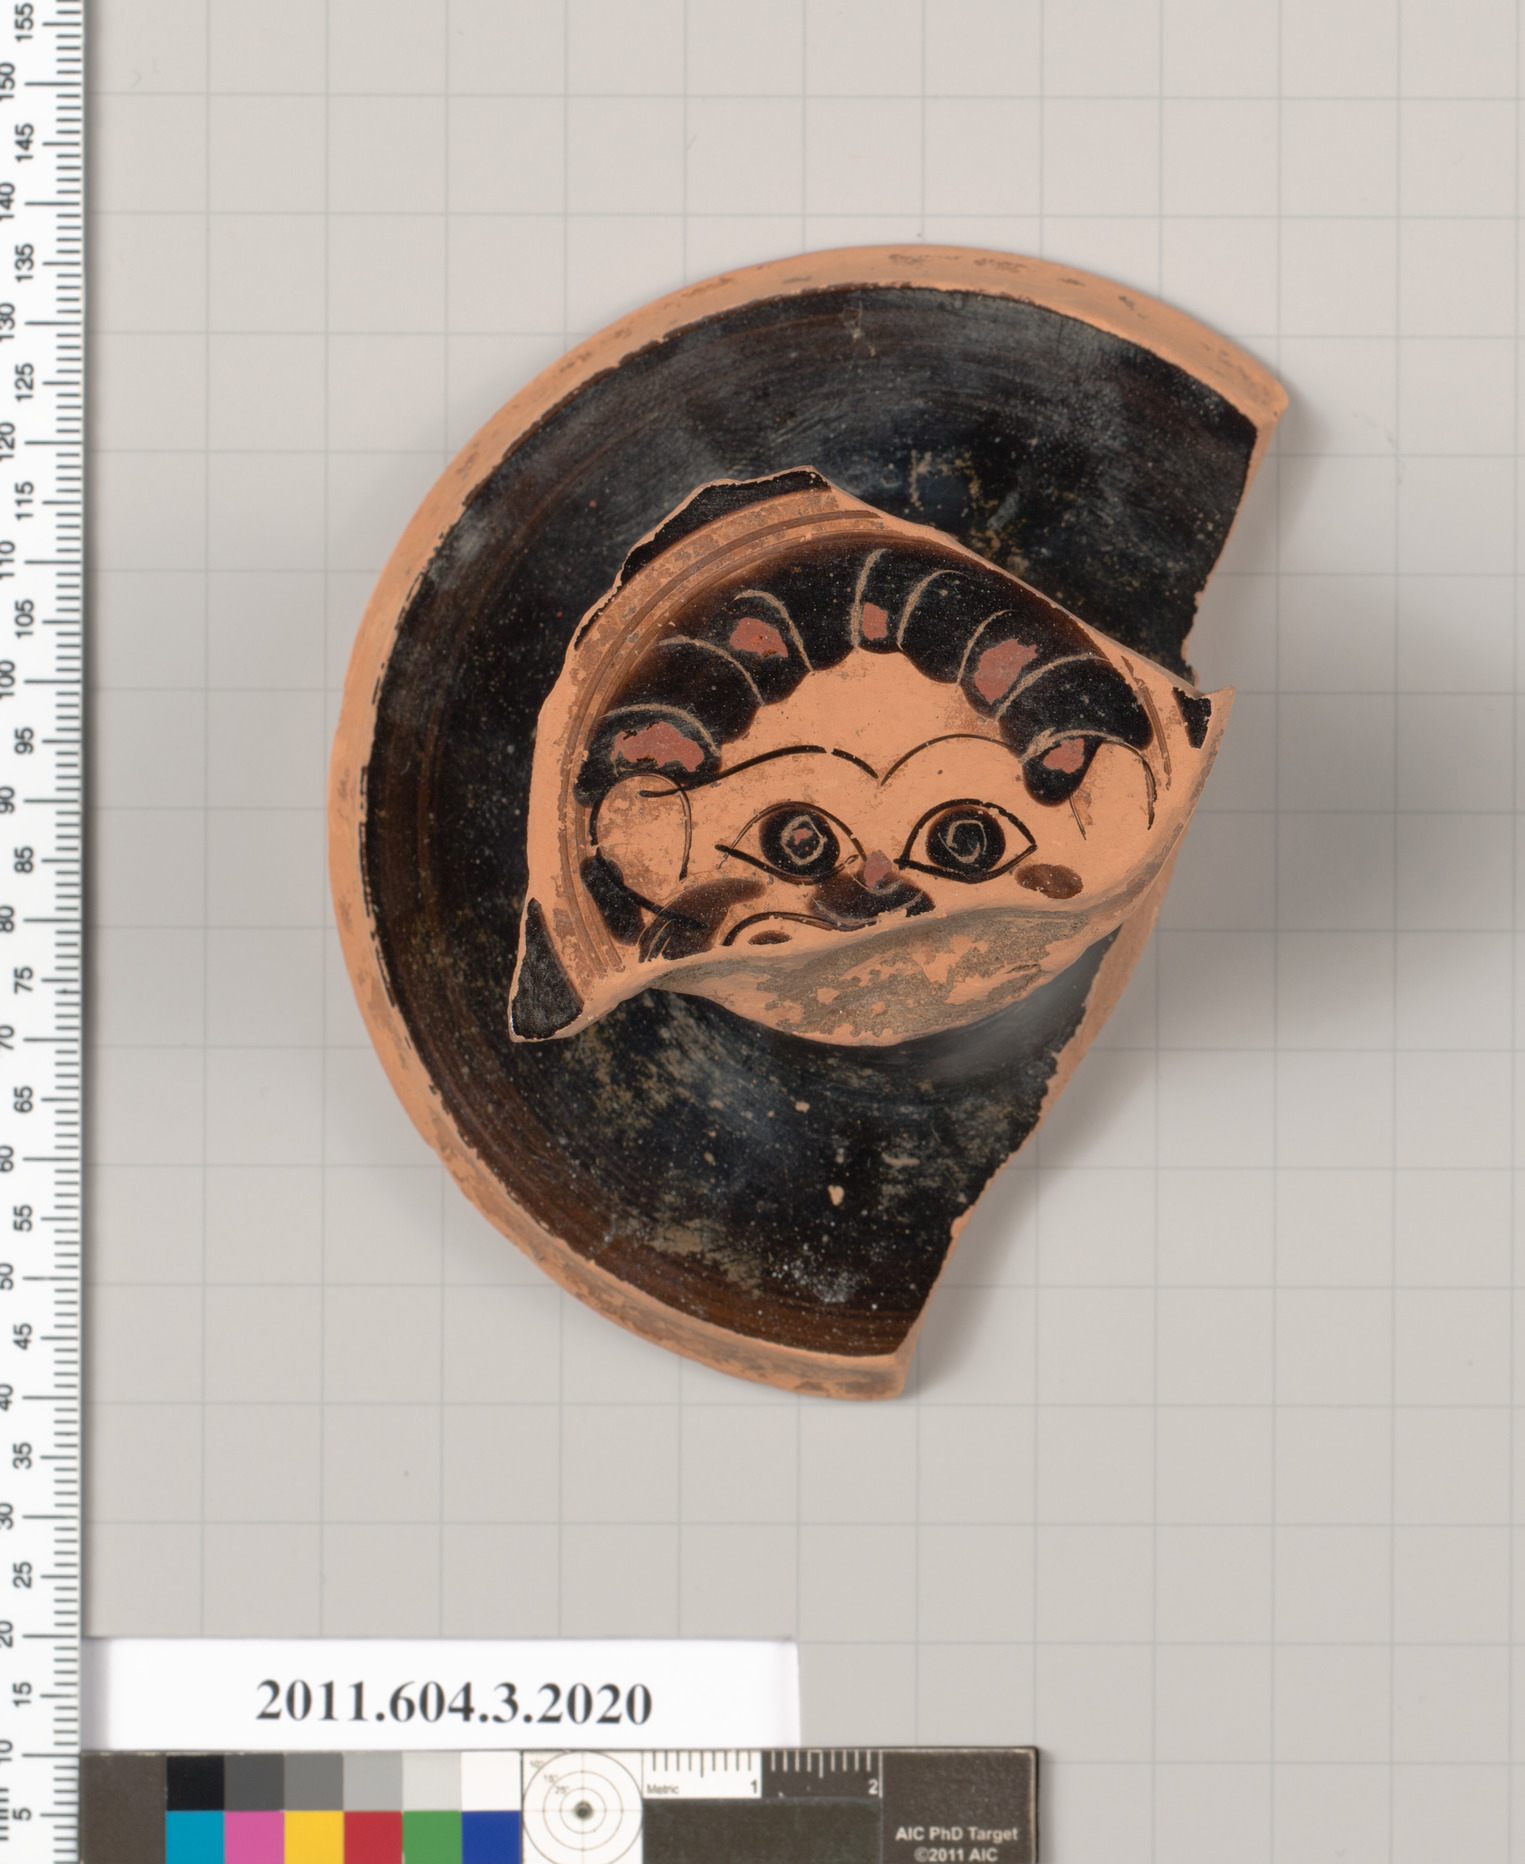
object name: kylix fragment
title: Terracotta fragment of a kylix (drinking cup)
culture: greek, attic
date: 550-526 BCE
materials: terracotta